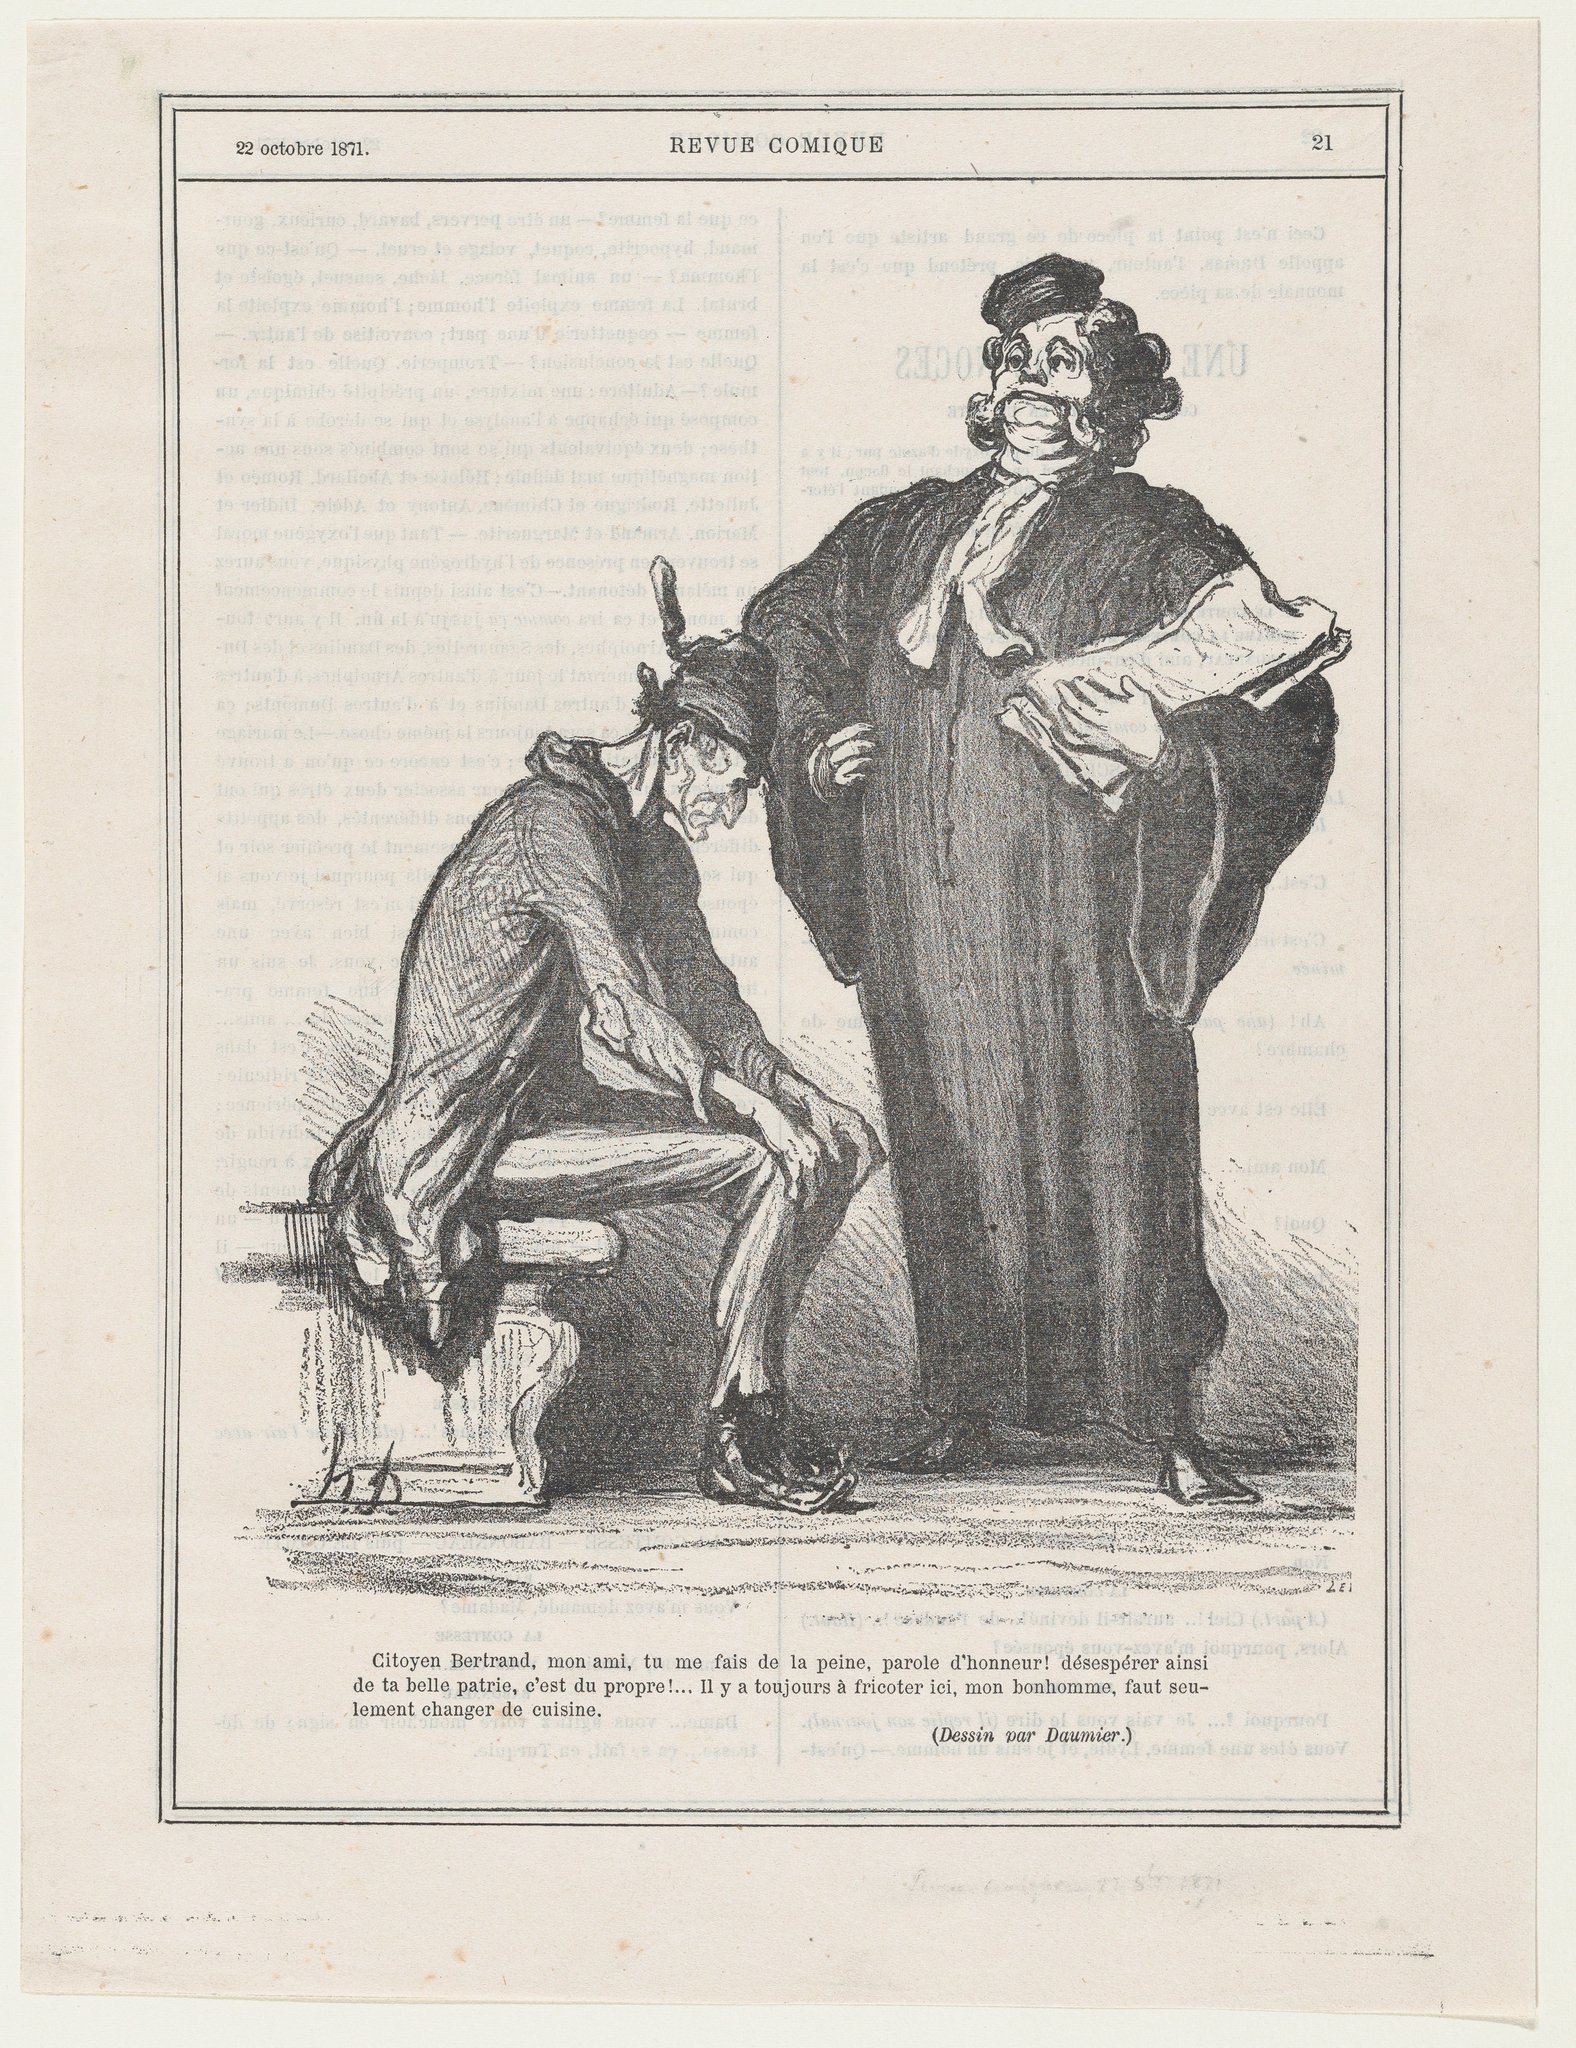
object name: print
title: Citizen Bertrand, my good friend, it grieves me to see you in such despair because of your country.... why worry, we'll find someone here to fry, my good friend.... all we need to do is change the kitchen!, published in 'Comic Review,' October 22, 1871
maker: honoré daumier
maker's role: artist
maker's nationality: french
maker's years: 1808-1879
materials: paper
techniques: lithograph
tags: satire,men